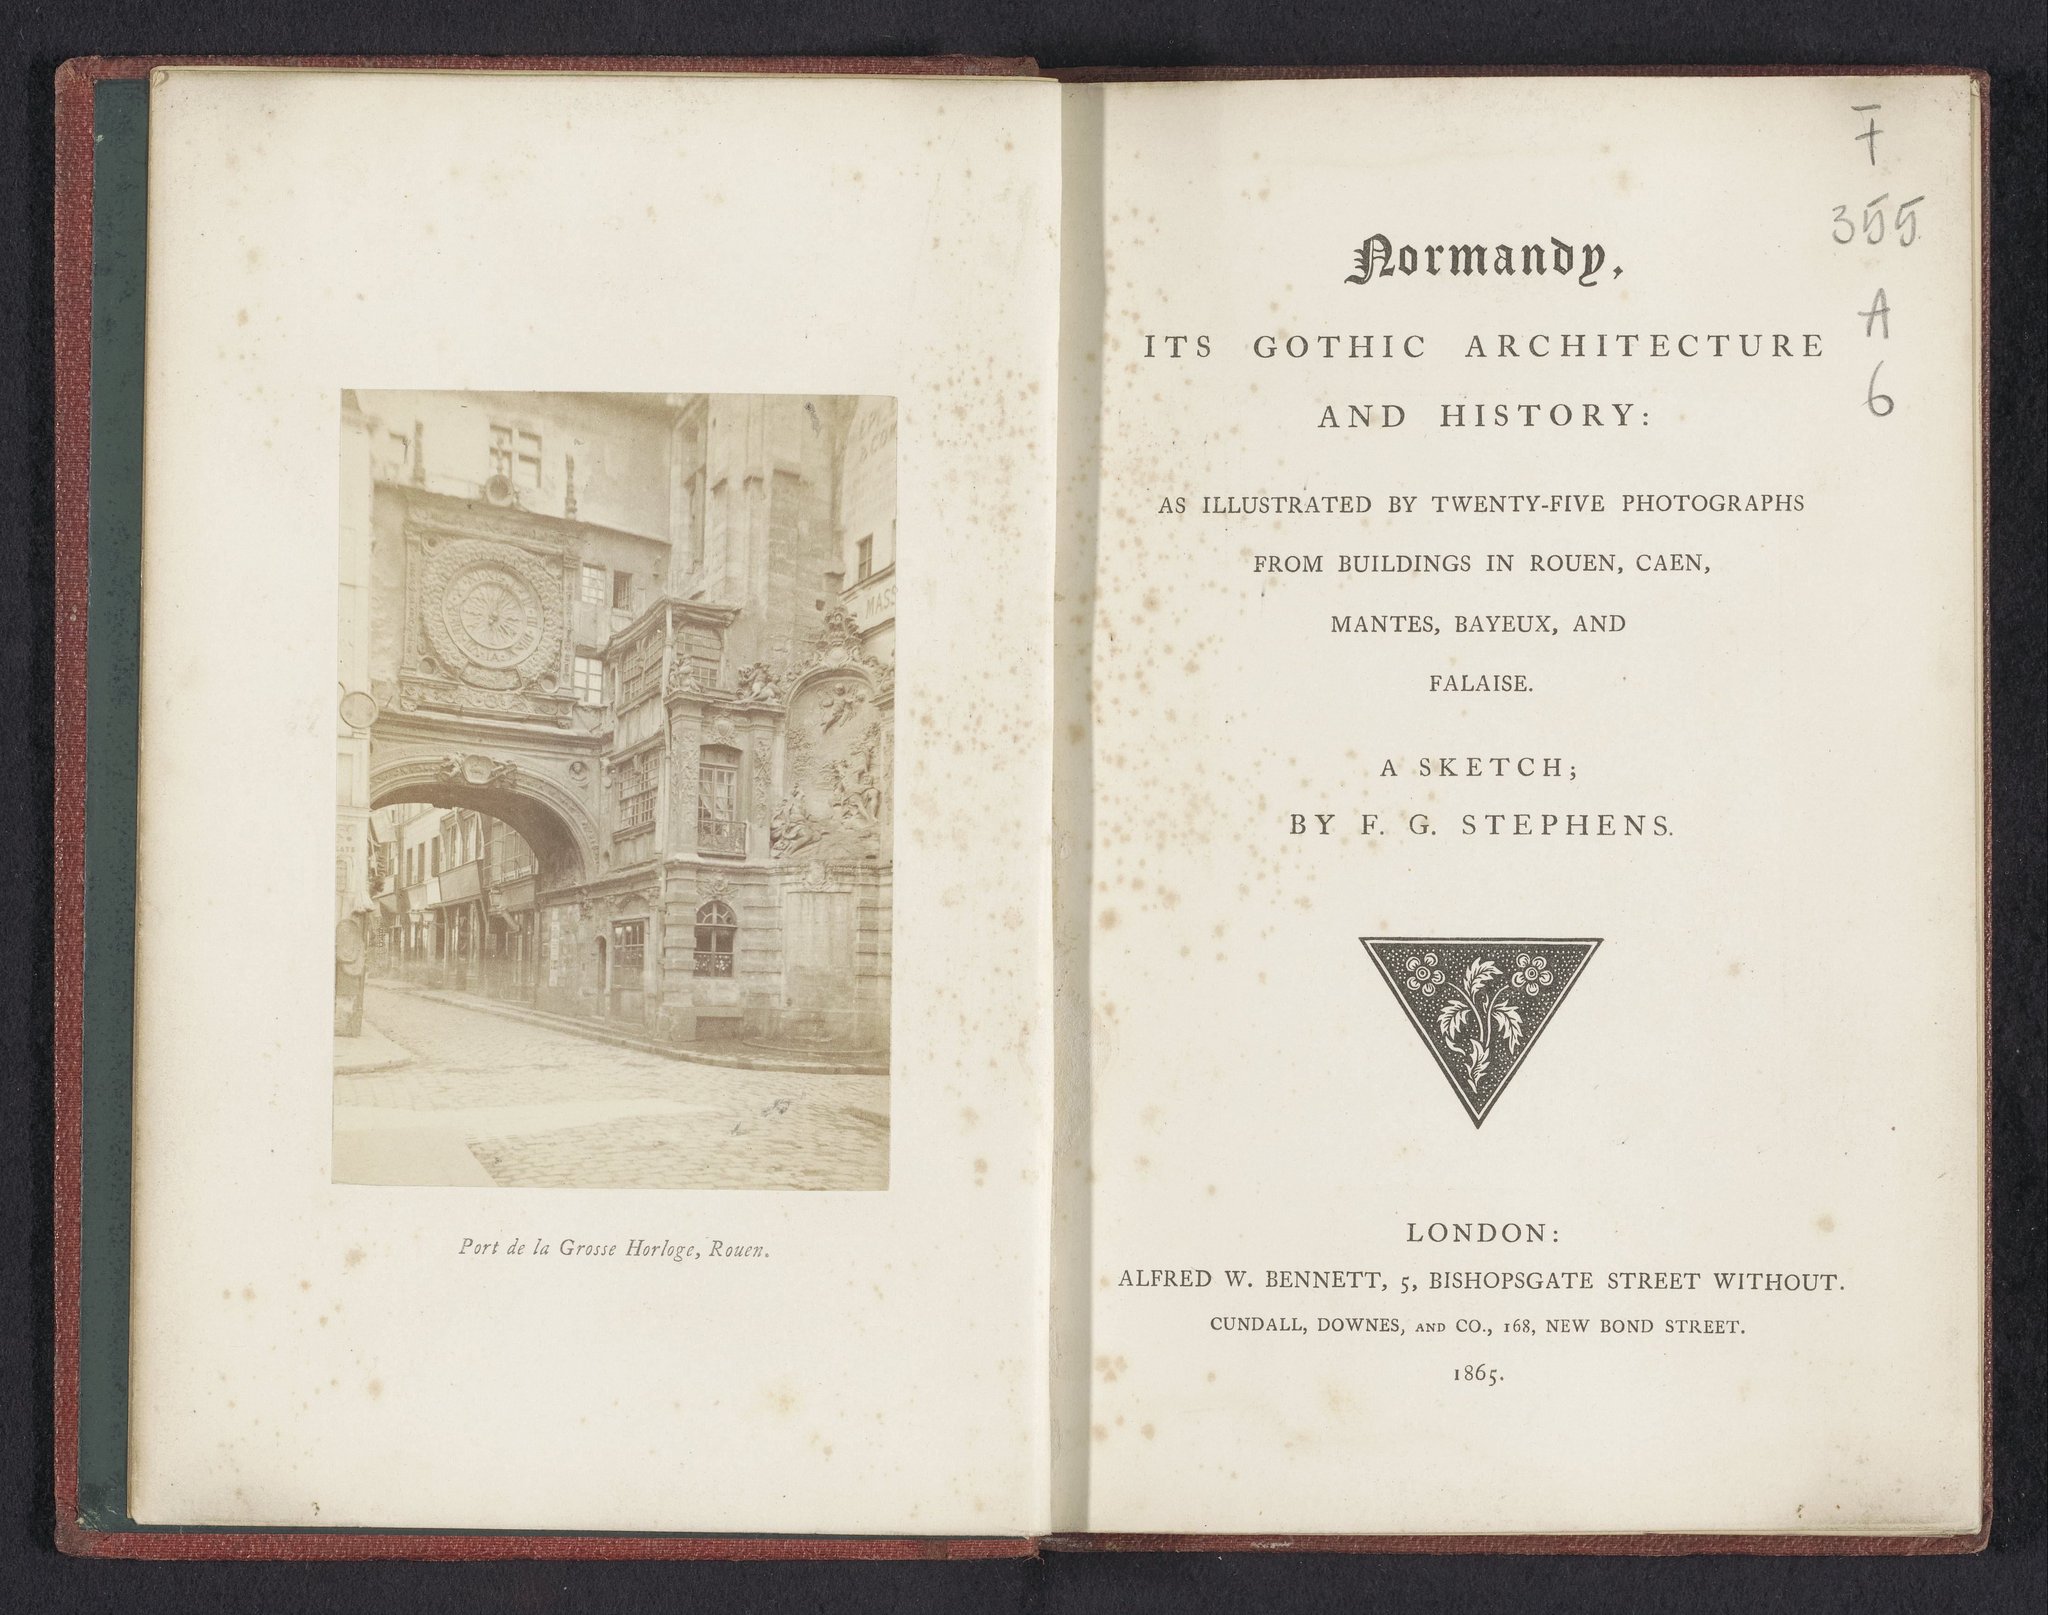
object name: photograph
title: Port de la Grosse Horloge, Rouen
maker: joseph cundall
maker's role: fotograaf, schrijver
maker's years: 1818-1895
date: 1855-1865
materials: photographic support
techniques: albumen print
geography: rouen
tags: tower, clock tower ~ monumental adornment, street